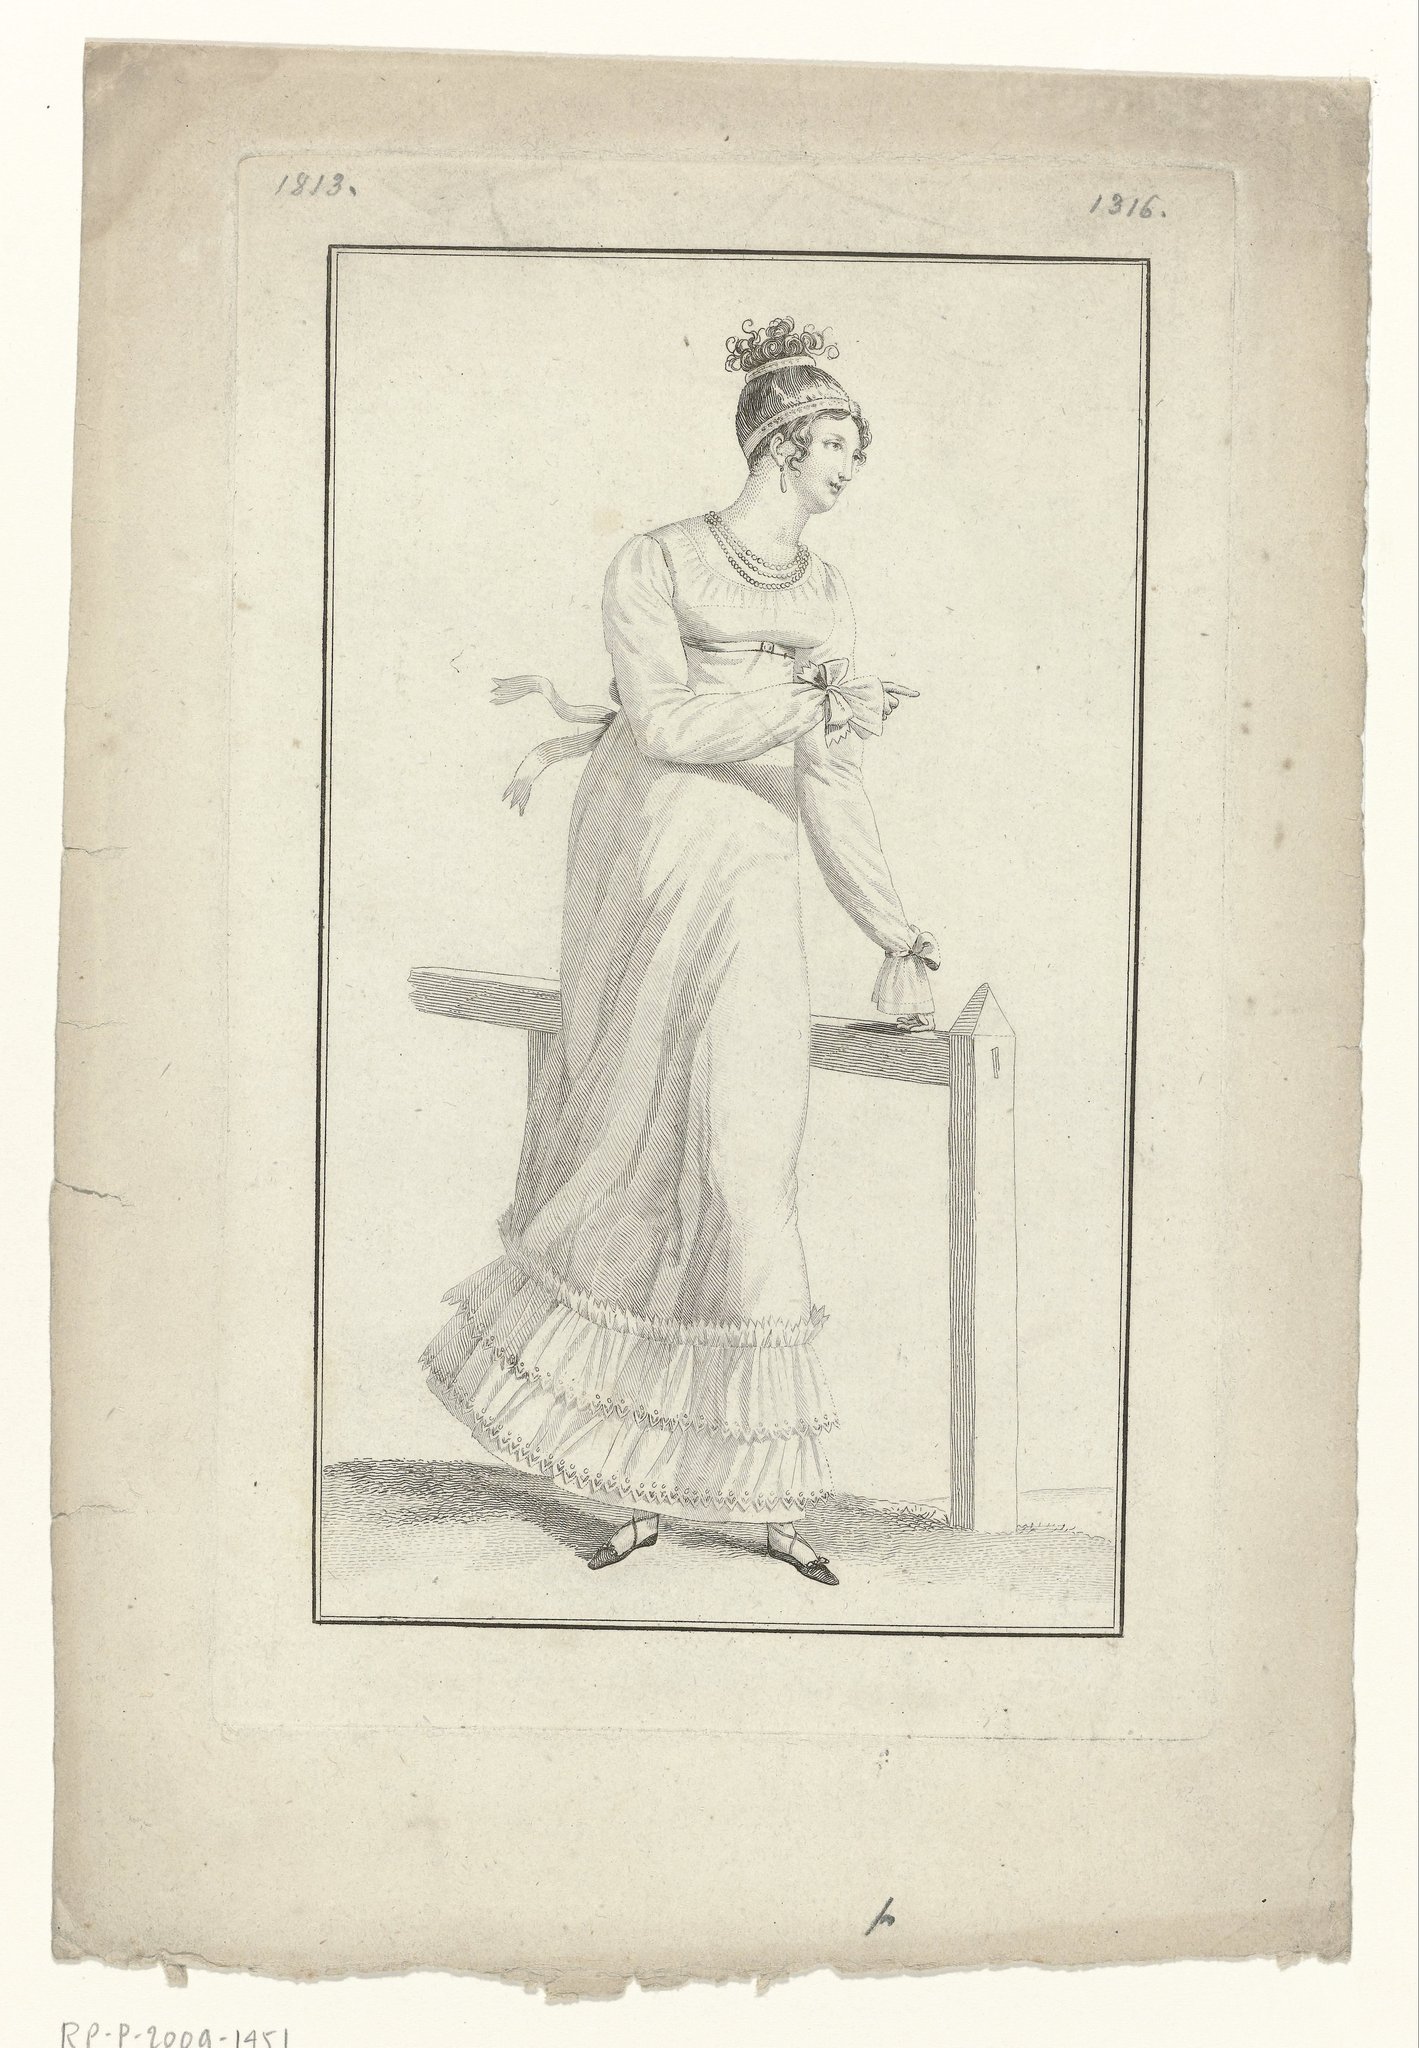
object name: fashion print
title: Journal des Dames et des Modes, Costume Parisien, 5 juin 1813 (1316)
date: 1813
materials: paper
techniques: engraving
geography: paris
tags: ear-rings (+ women's clothes), diadem, tiara (+ women's clothes), fence, wall, paling, fashion plates, shoes, sandals (+ women's clothes), dress, gown (+ women's clothes), necklace (+ women's clothes), belt, girdle, waistband (+ women's clothes)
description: Vrouw, staande bij een hek, in een japon met lange mouwen en strikken bij de polsen: 'robe à la Vierge'. In het haar twee haarbanden. Verdere accessoires: oorbel in het rechteroor, collier bestaande uit drie snoeren, ceintuur, platte schoenen met gekruiste banden en strikken. Proefdruk van een prent uit het modetijdschrift Journal des Dames et des Modes, uitgegeven door Pierre de la Mésangère, Parijs, 1797-1839.